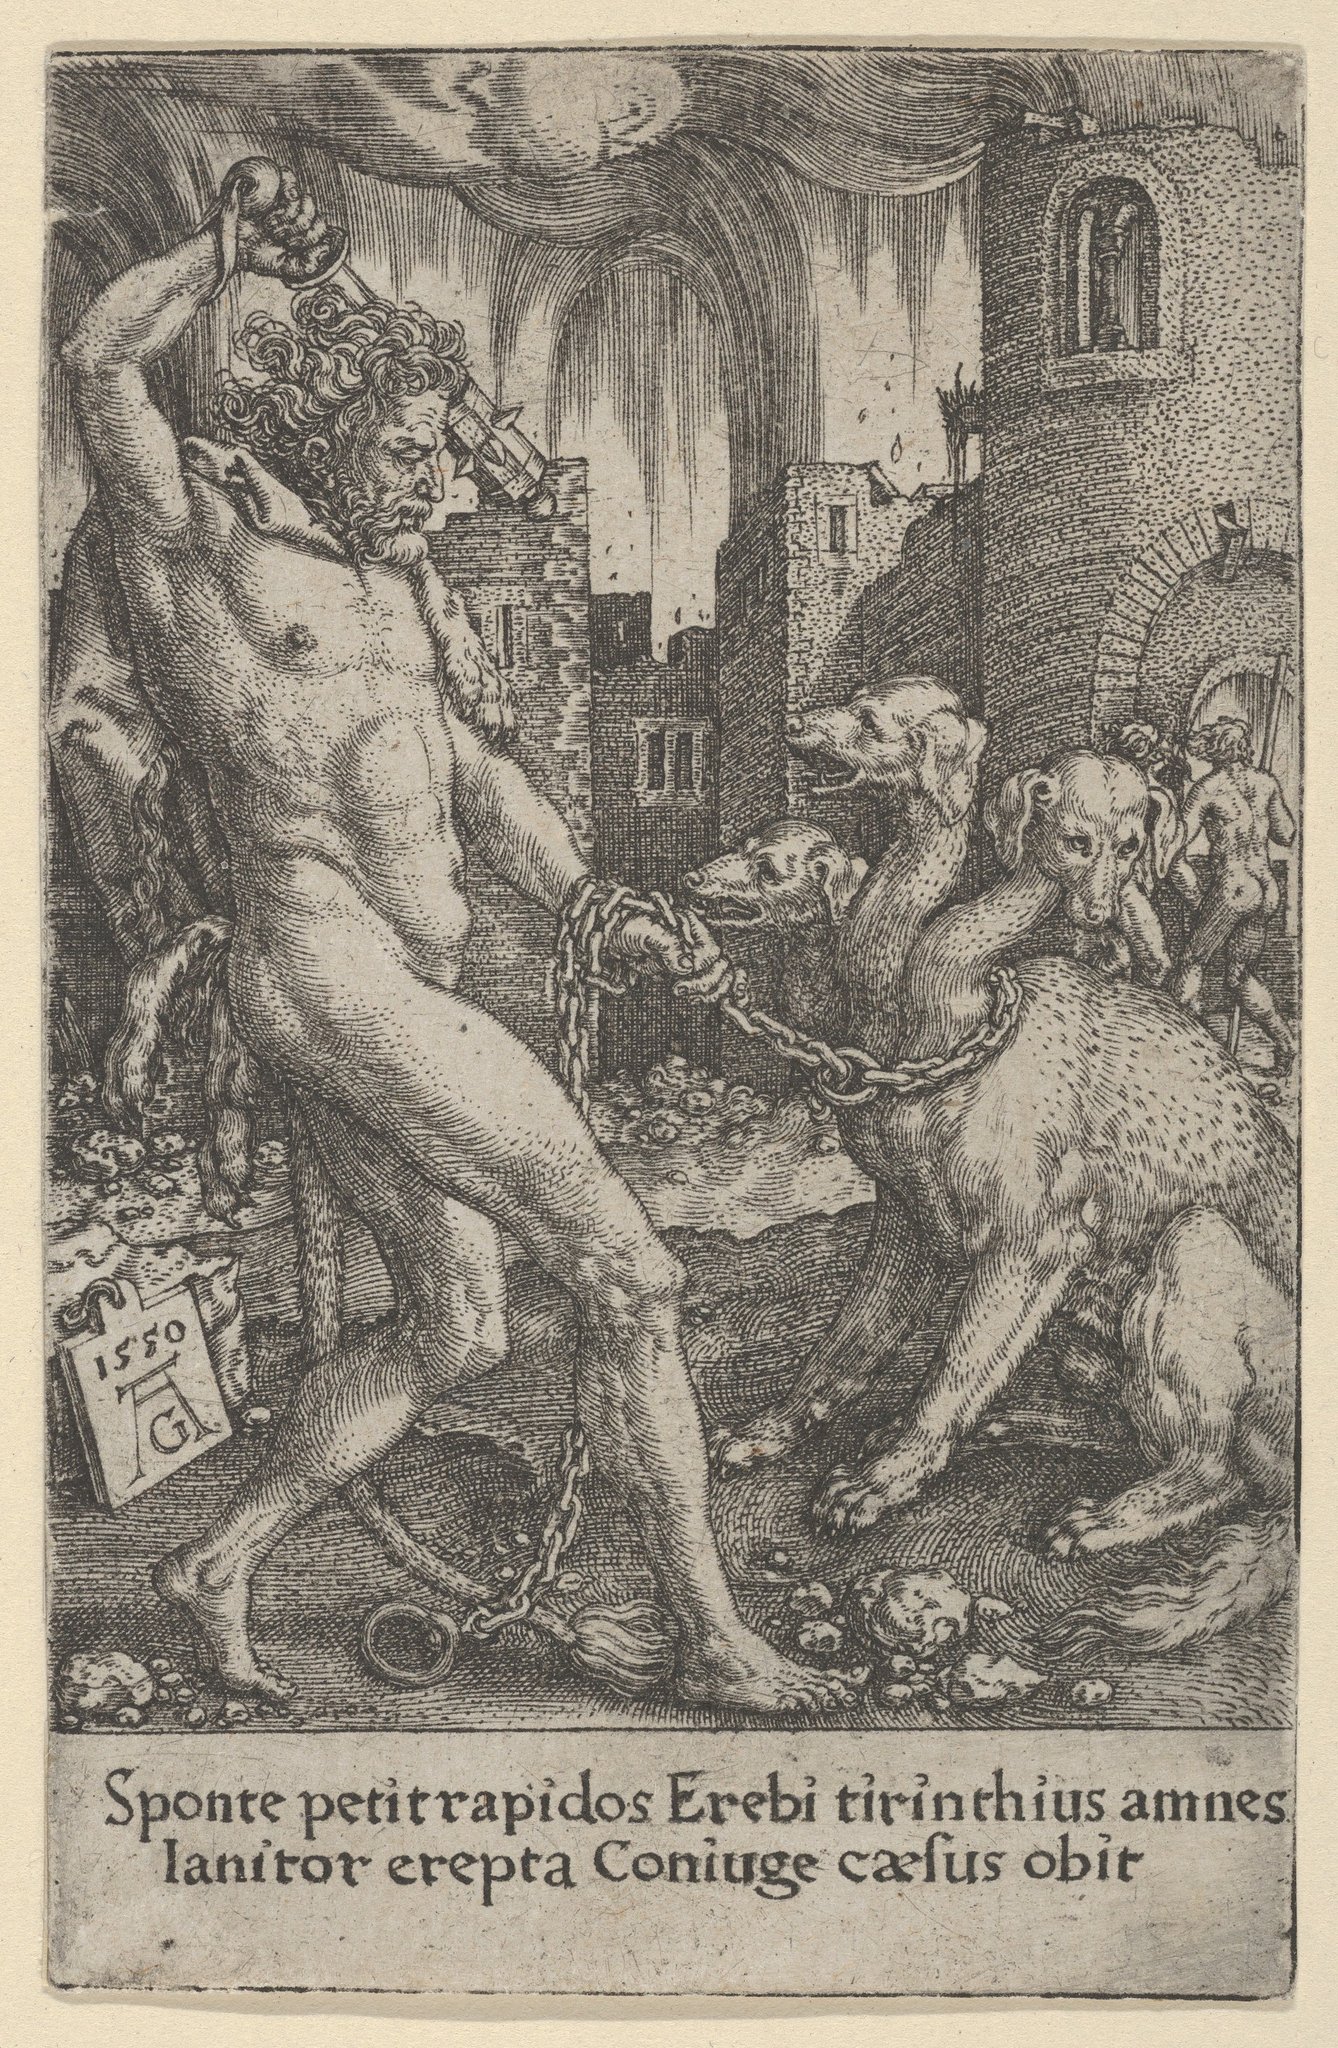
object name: print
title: Hercules and Cerberus, from The Labors of Hercules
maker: heinrich aldegrever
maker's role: artist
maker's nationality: german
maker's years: 1502-1561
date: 1550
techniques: engraving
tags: hercules